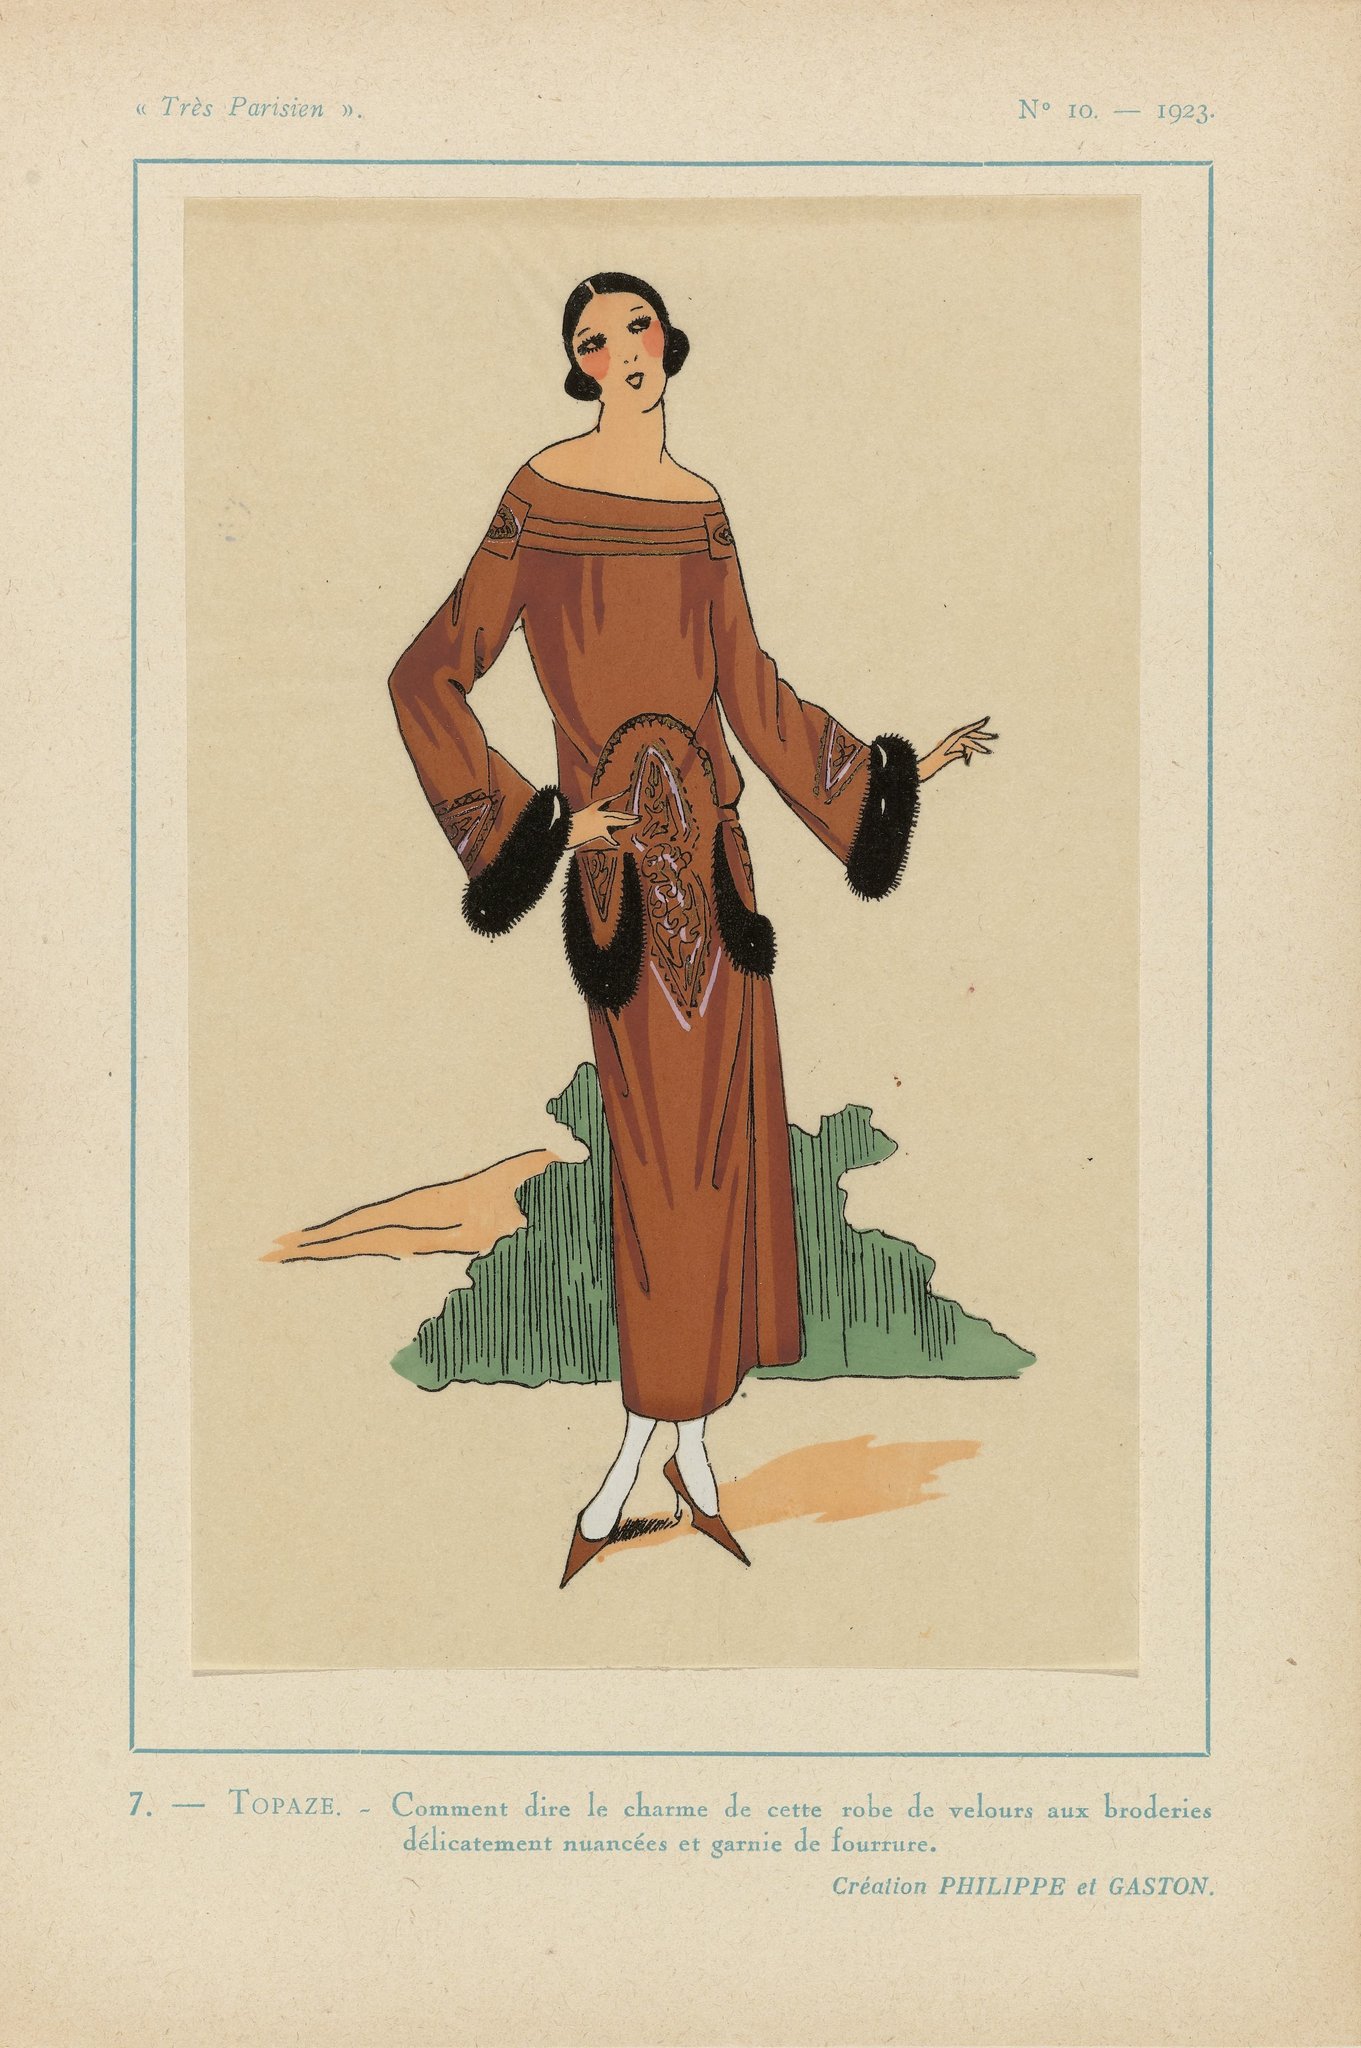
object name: fashion print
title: Très Parisien, 1923, No 10: 7.-TOPAZE. - Comment dire le charme...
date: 1923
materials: paper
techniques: hand coloring, letterpress printing, lithography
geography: paris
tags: embroidery (ornamentation) (+ women's clothes), border, ribbon, braid (+ fur used for clothes), fashion plates, dress, gown (+ women's clothes)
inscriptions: caption: ‘7. - TOPAZE. - Comment dire le charme de cette robe de velours aux broderies délicatement nuancées et garnie de fourrure. / Création PHILIPPE et GASTON.’, title: ‘Très Parisien / No 10. - 1923’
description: Jurk van fluweel met fijn borduurwerk en gegarneerd met bont. Ontwerp van Philippe et Gaston. Prent uit het modetijdschrift Très Parisien (1920-1936).